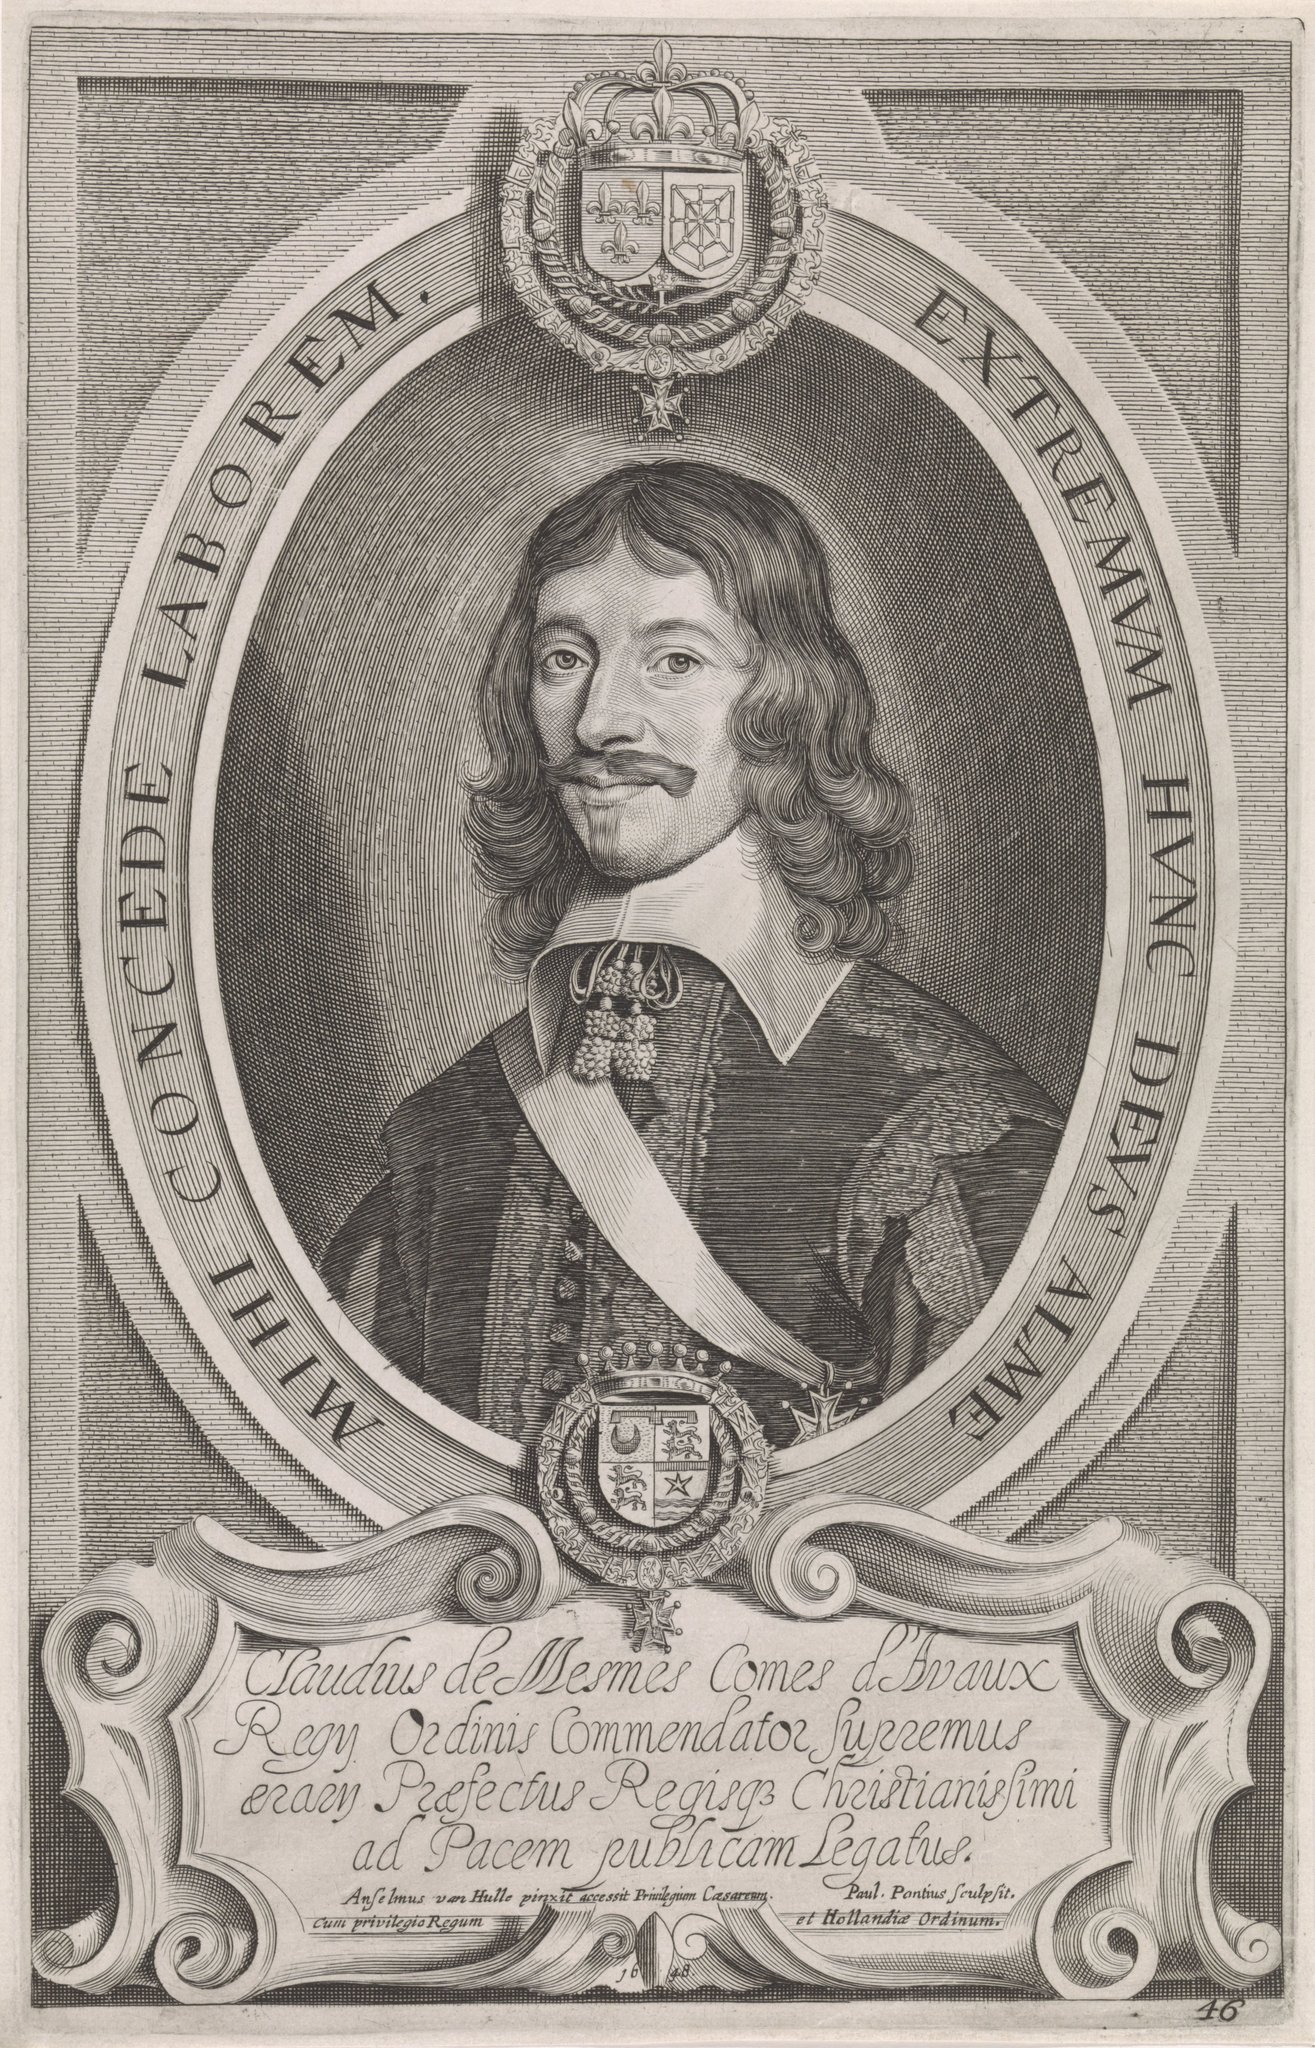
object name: print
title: Portret van Claudius de Mesmes, graaf d'Avaux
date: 1648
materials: paper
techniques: engraving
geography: antwerp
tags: knighthood order of the holy spirit, armorial bearing, heraldry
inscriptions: collector's mark: Lugt 2228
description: Prent ook opgenomen in: Pacificatores orbis christiani, sive Icones principum, ducum et legatorum, qui Monasterii atque Osnabrugæ pacem Europæ reconciliarunt (...). = Pronkbeelden der vorsten, en vredehandelaars. Rotterdam: Pieter van der Slaart, 1697.